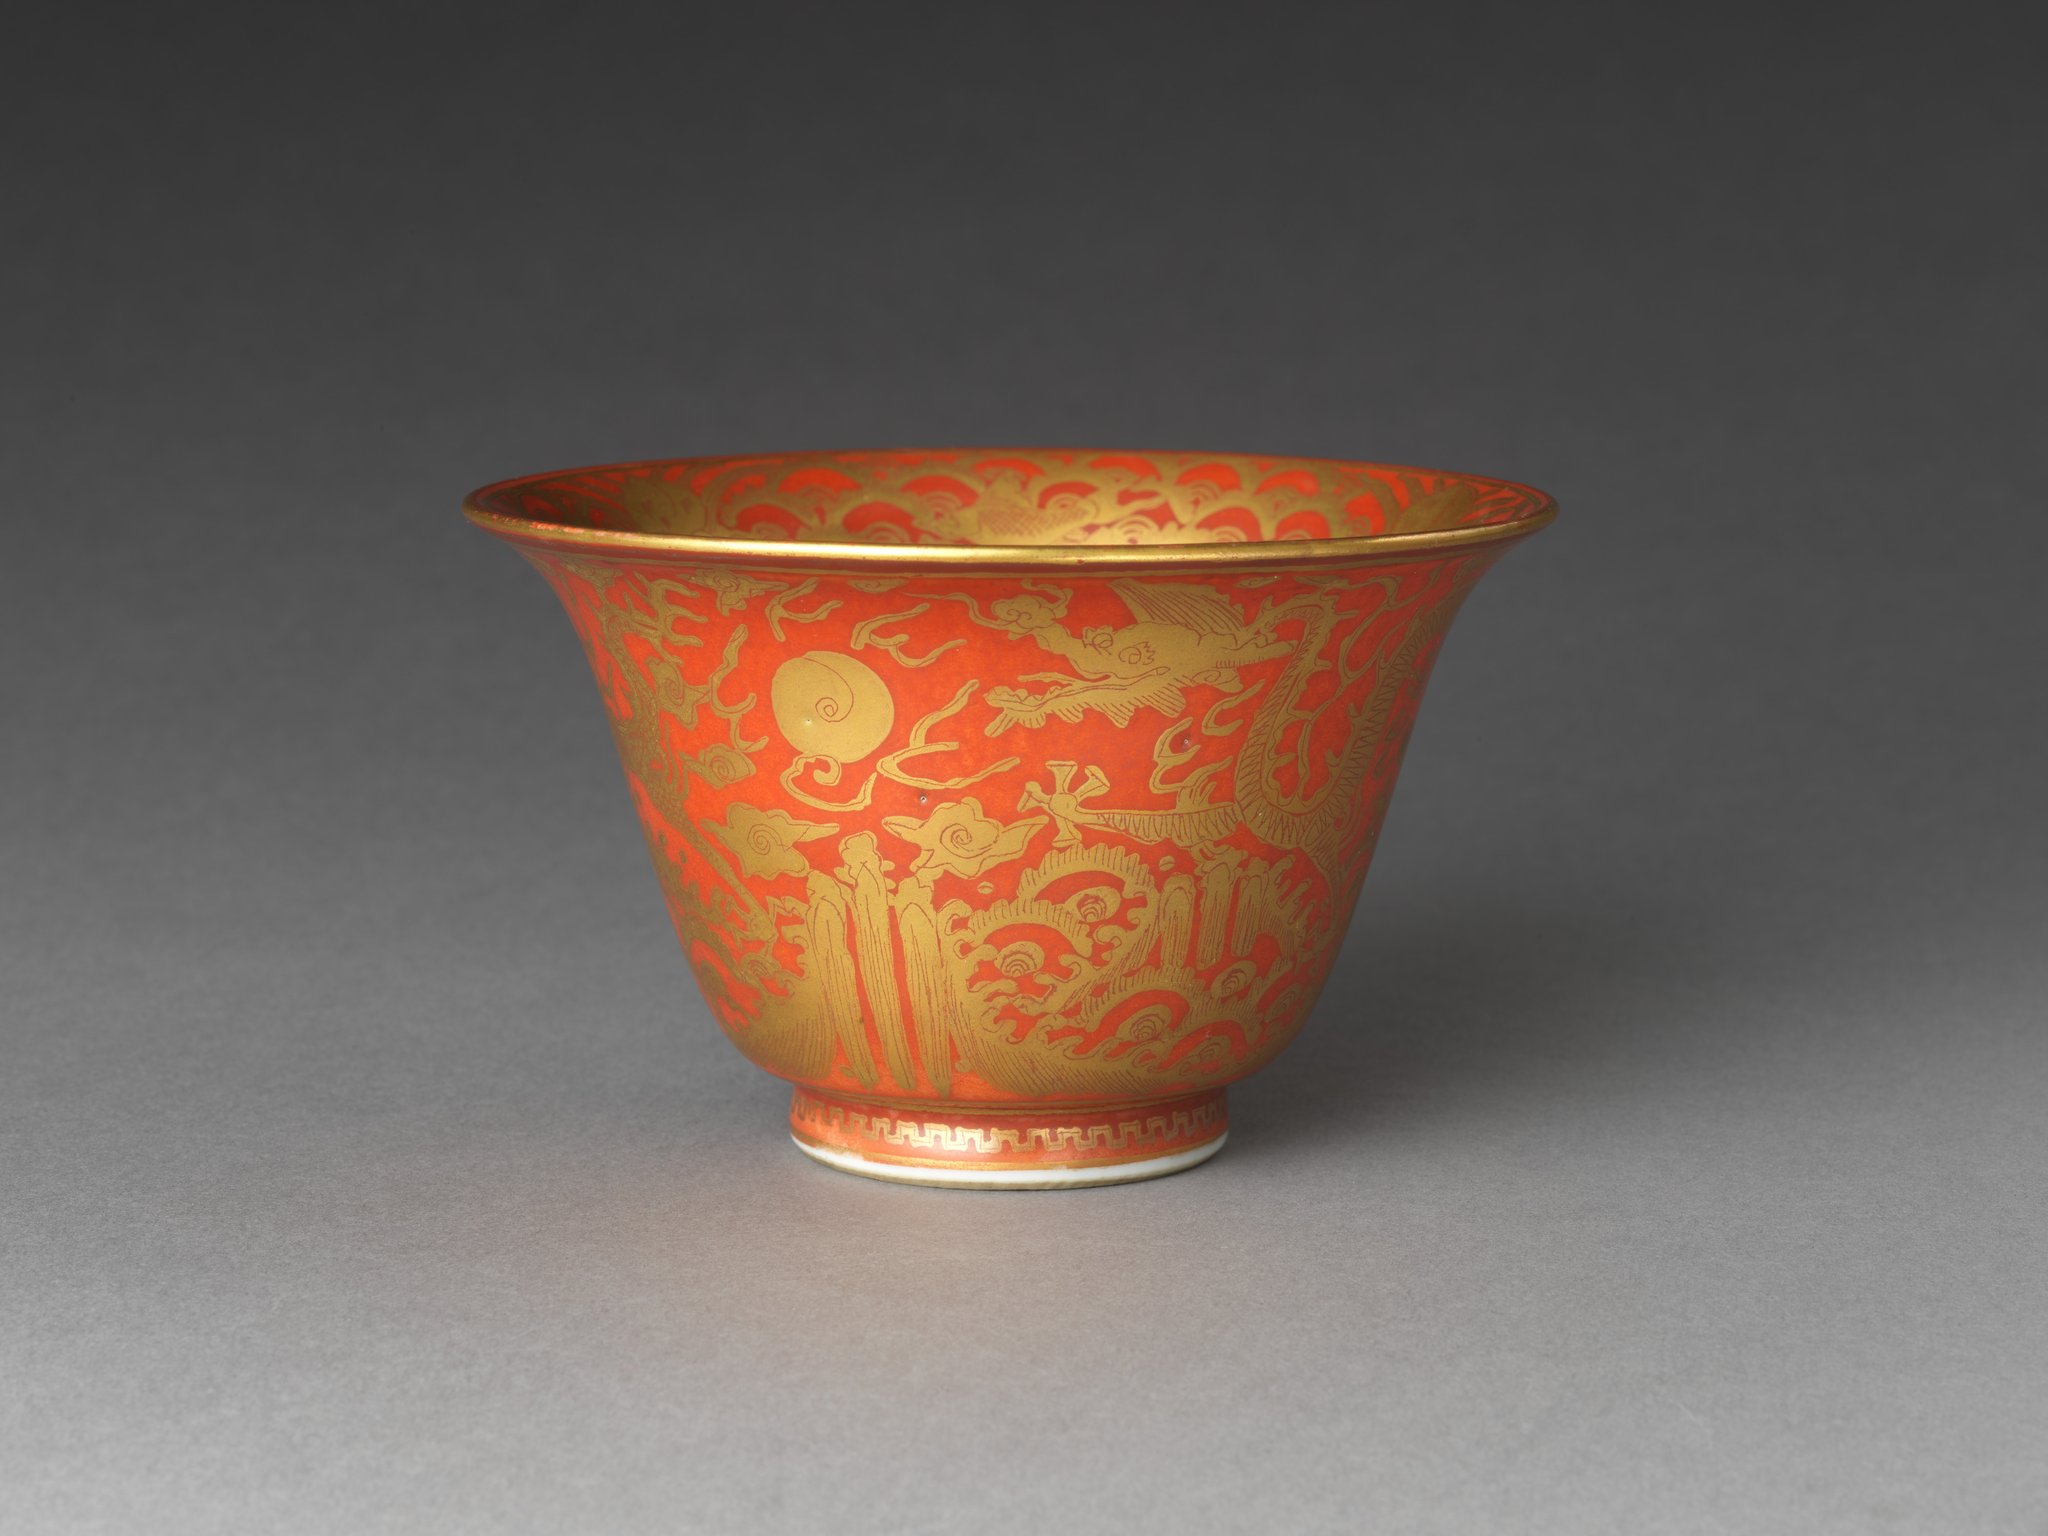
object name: bowl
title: Bowl with Dragons and Auspicious Motifs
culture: japanese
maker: eiraku tokuzen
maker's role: artist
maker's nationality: japanese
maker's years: 1853-1909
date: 1851-1900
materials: cobalt, glaze, gold, porcelain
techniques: painting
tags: dragons